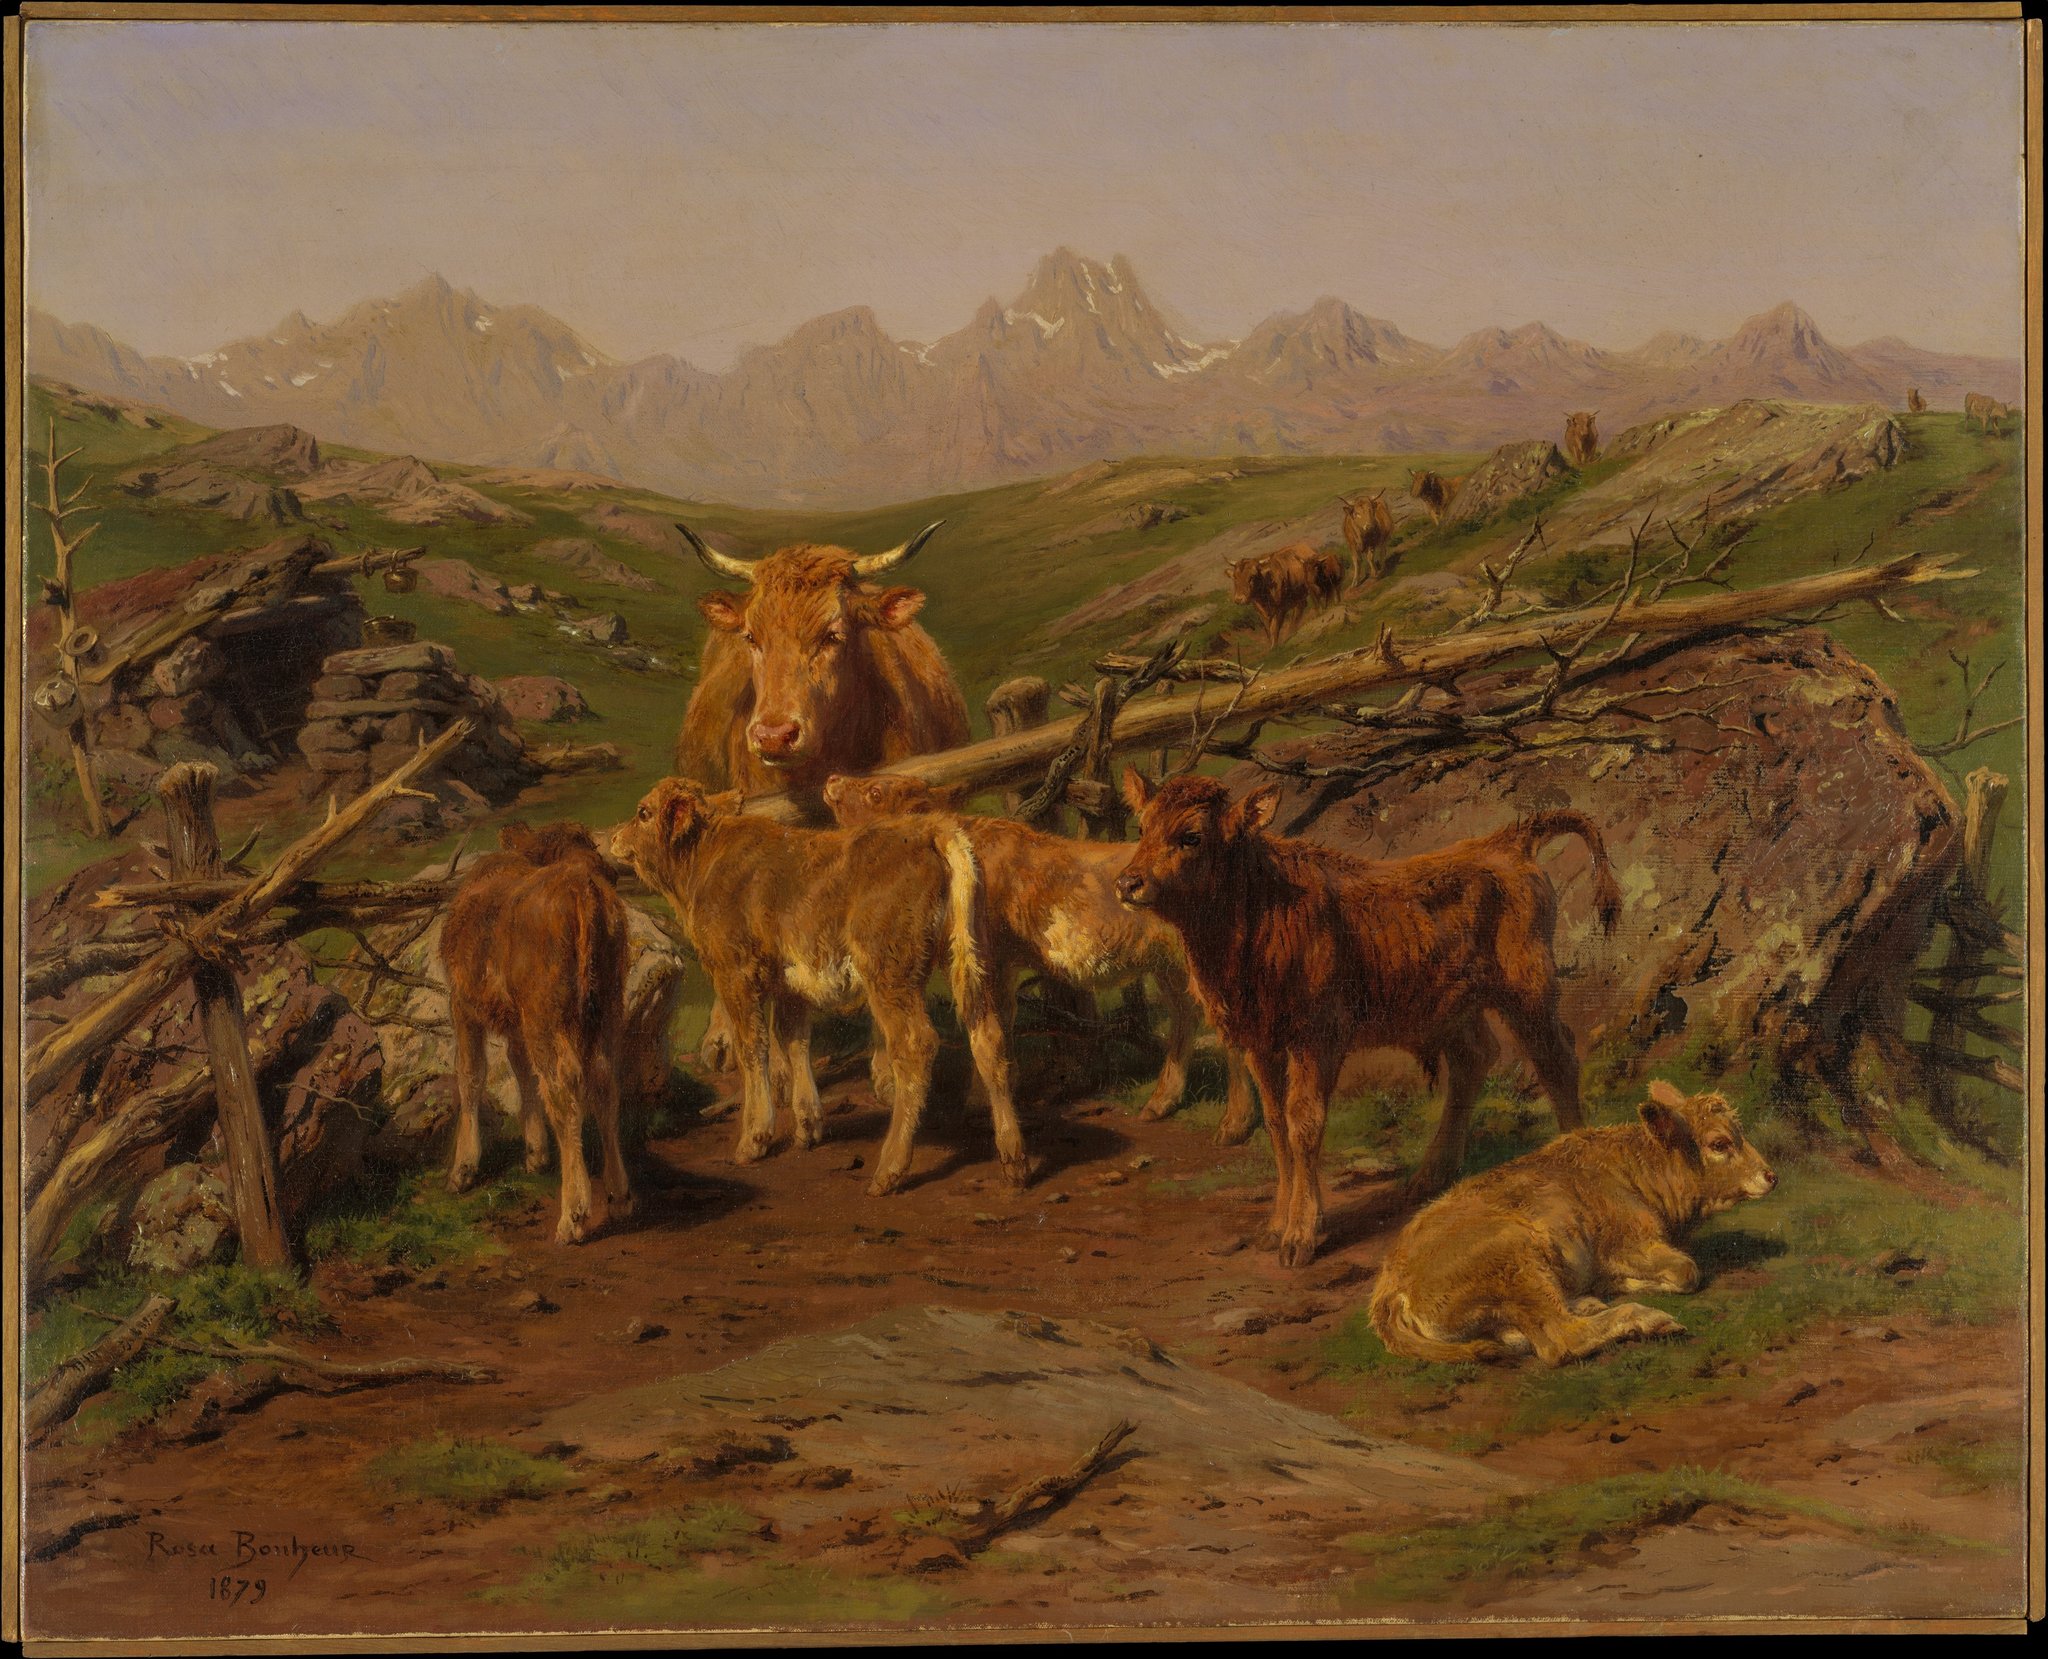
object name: painting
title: Weaning the Calves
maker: rosa bonheur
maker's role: artist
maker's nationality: french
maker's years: 1822-1899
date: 1879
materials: canvas, oil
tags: cows